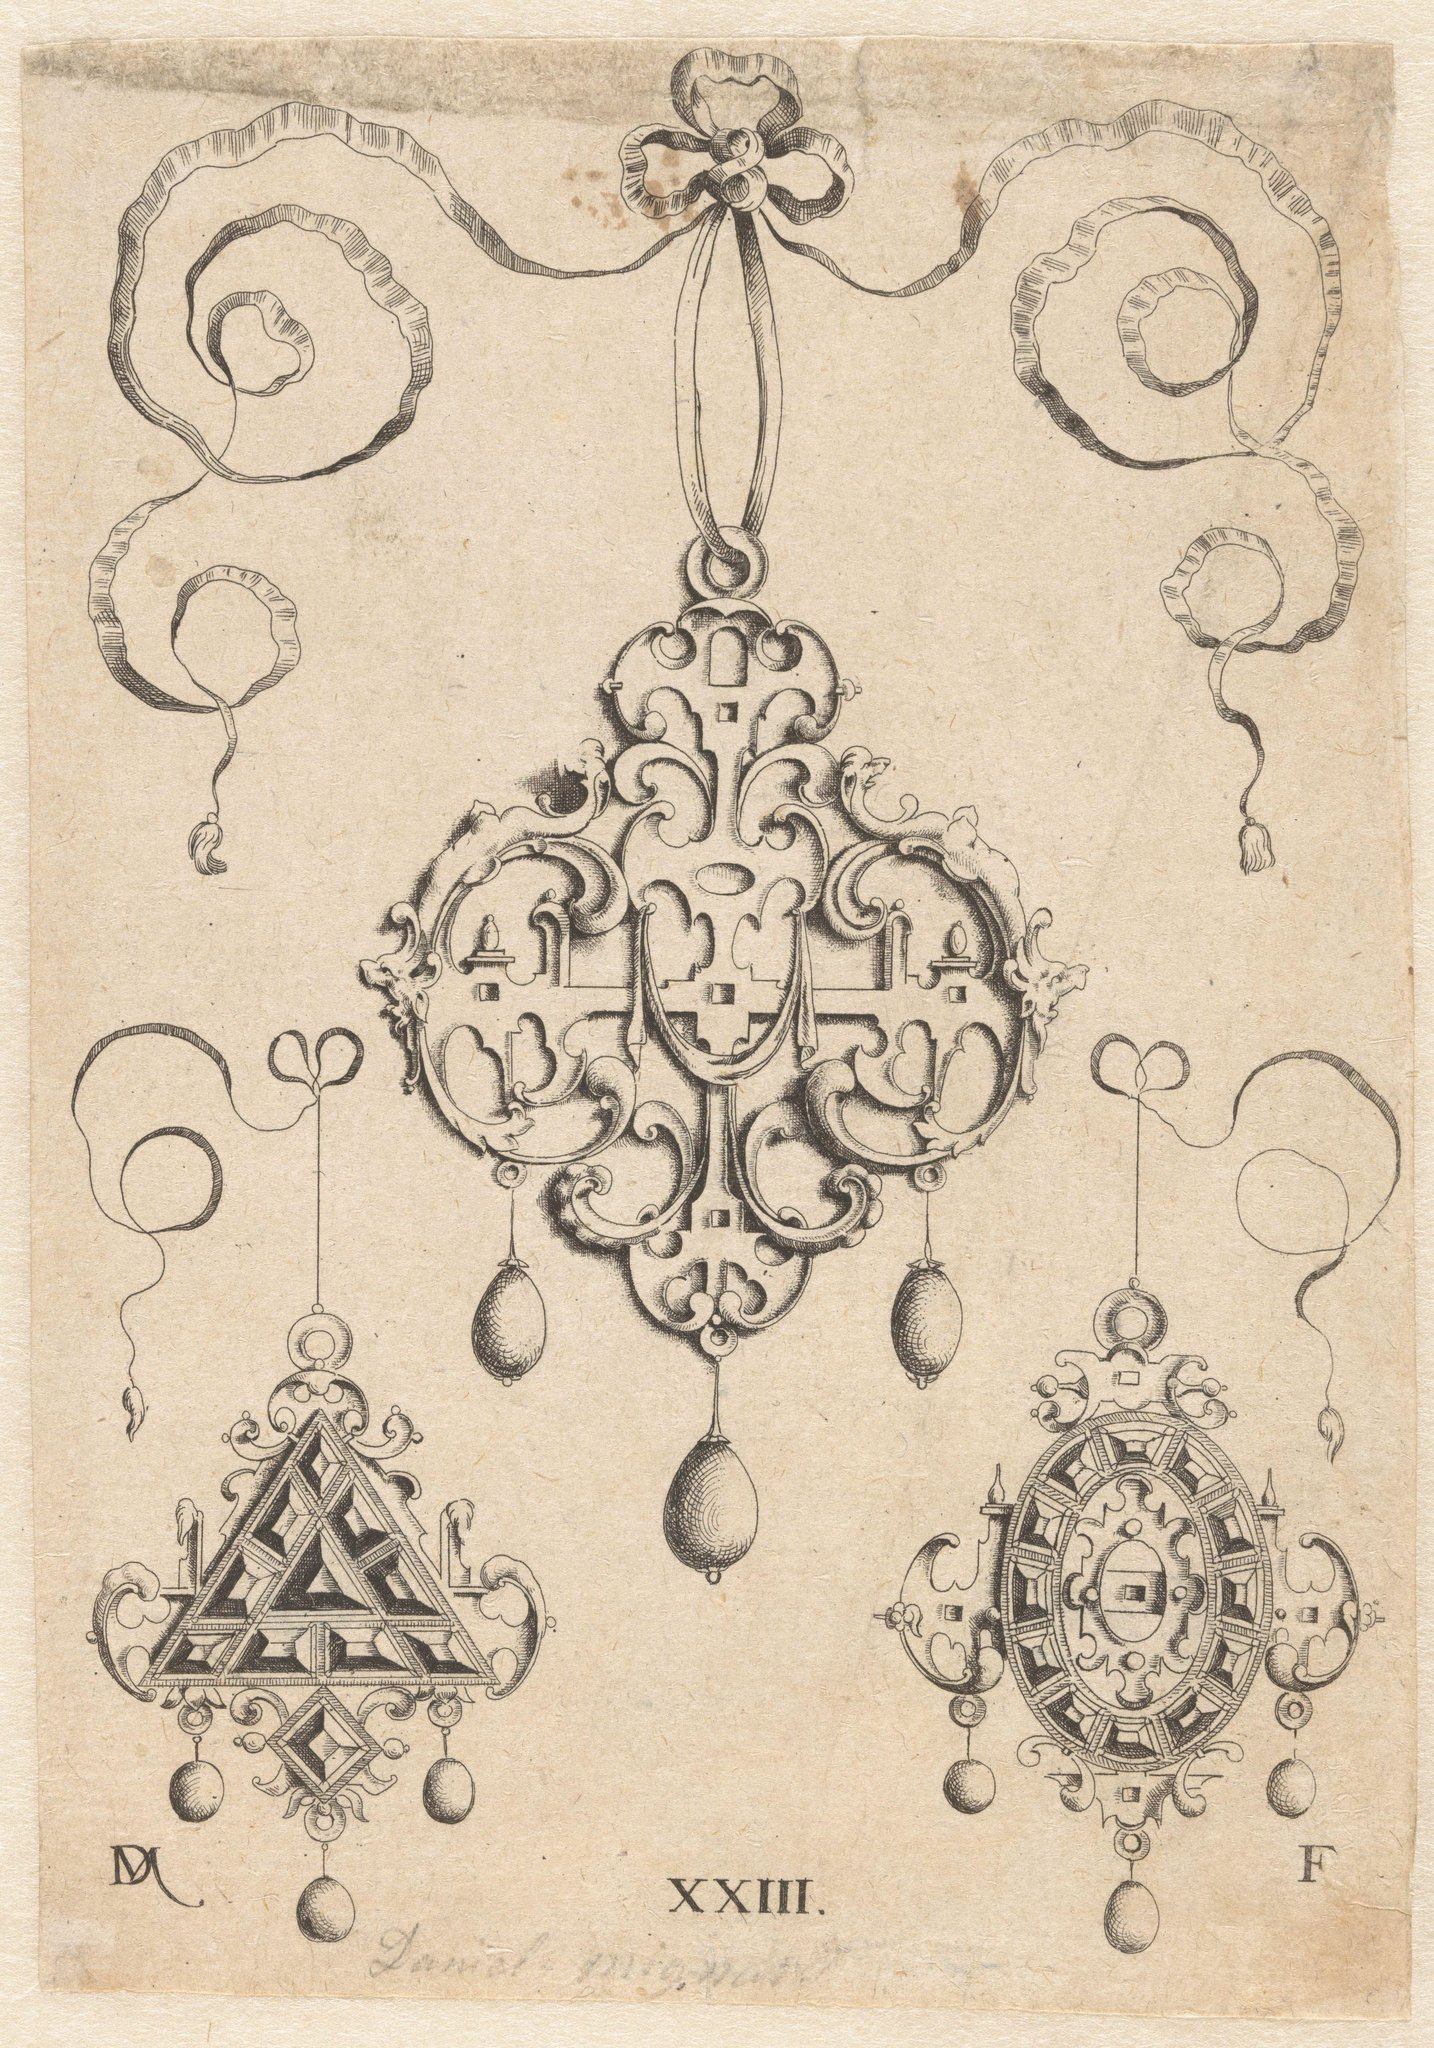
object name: ornament print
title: Drie hangers met rolwerk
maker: daniel mignot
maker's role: print maker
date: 1593-1596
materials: paper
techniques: engraving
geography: augsburg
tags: ornaments ~ art, scrollwork, strapwork ~ ornament, pendant, trinket, 'breloque'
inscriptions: collector's mark: Lugt 2760, inscription: ‘Daniel Mignot’, collector's mark: Lugt 2228, signature: ‘DM F’, number: ‘XXIII’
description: Drie ontwerpen voor hangers bestaande uit rolwerk. De hanger linksonder is in de vorm van een driehoek en de hanger rechtsonder is in de vorm van een ovaal.